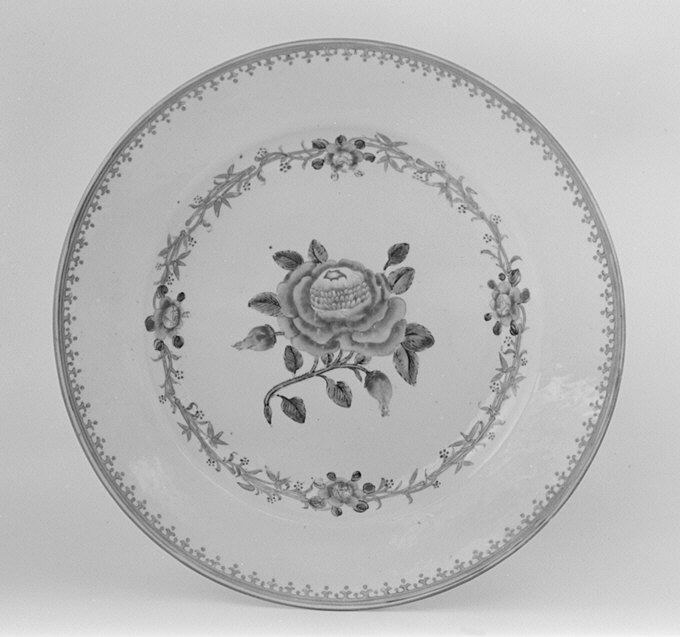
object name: plate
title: Plate (one of two)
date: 1750-1770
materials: hard paste porcelain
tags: flowers